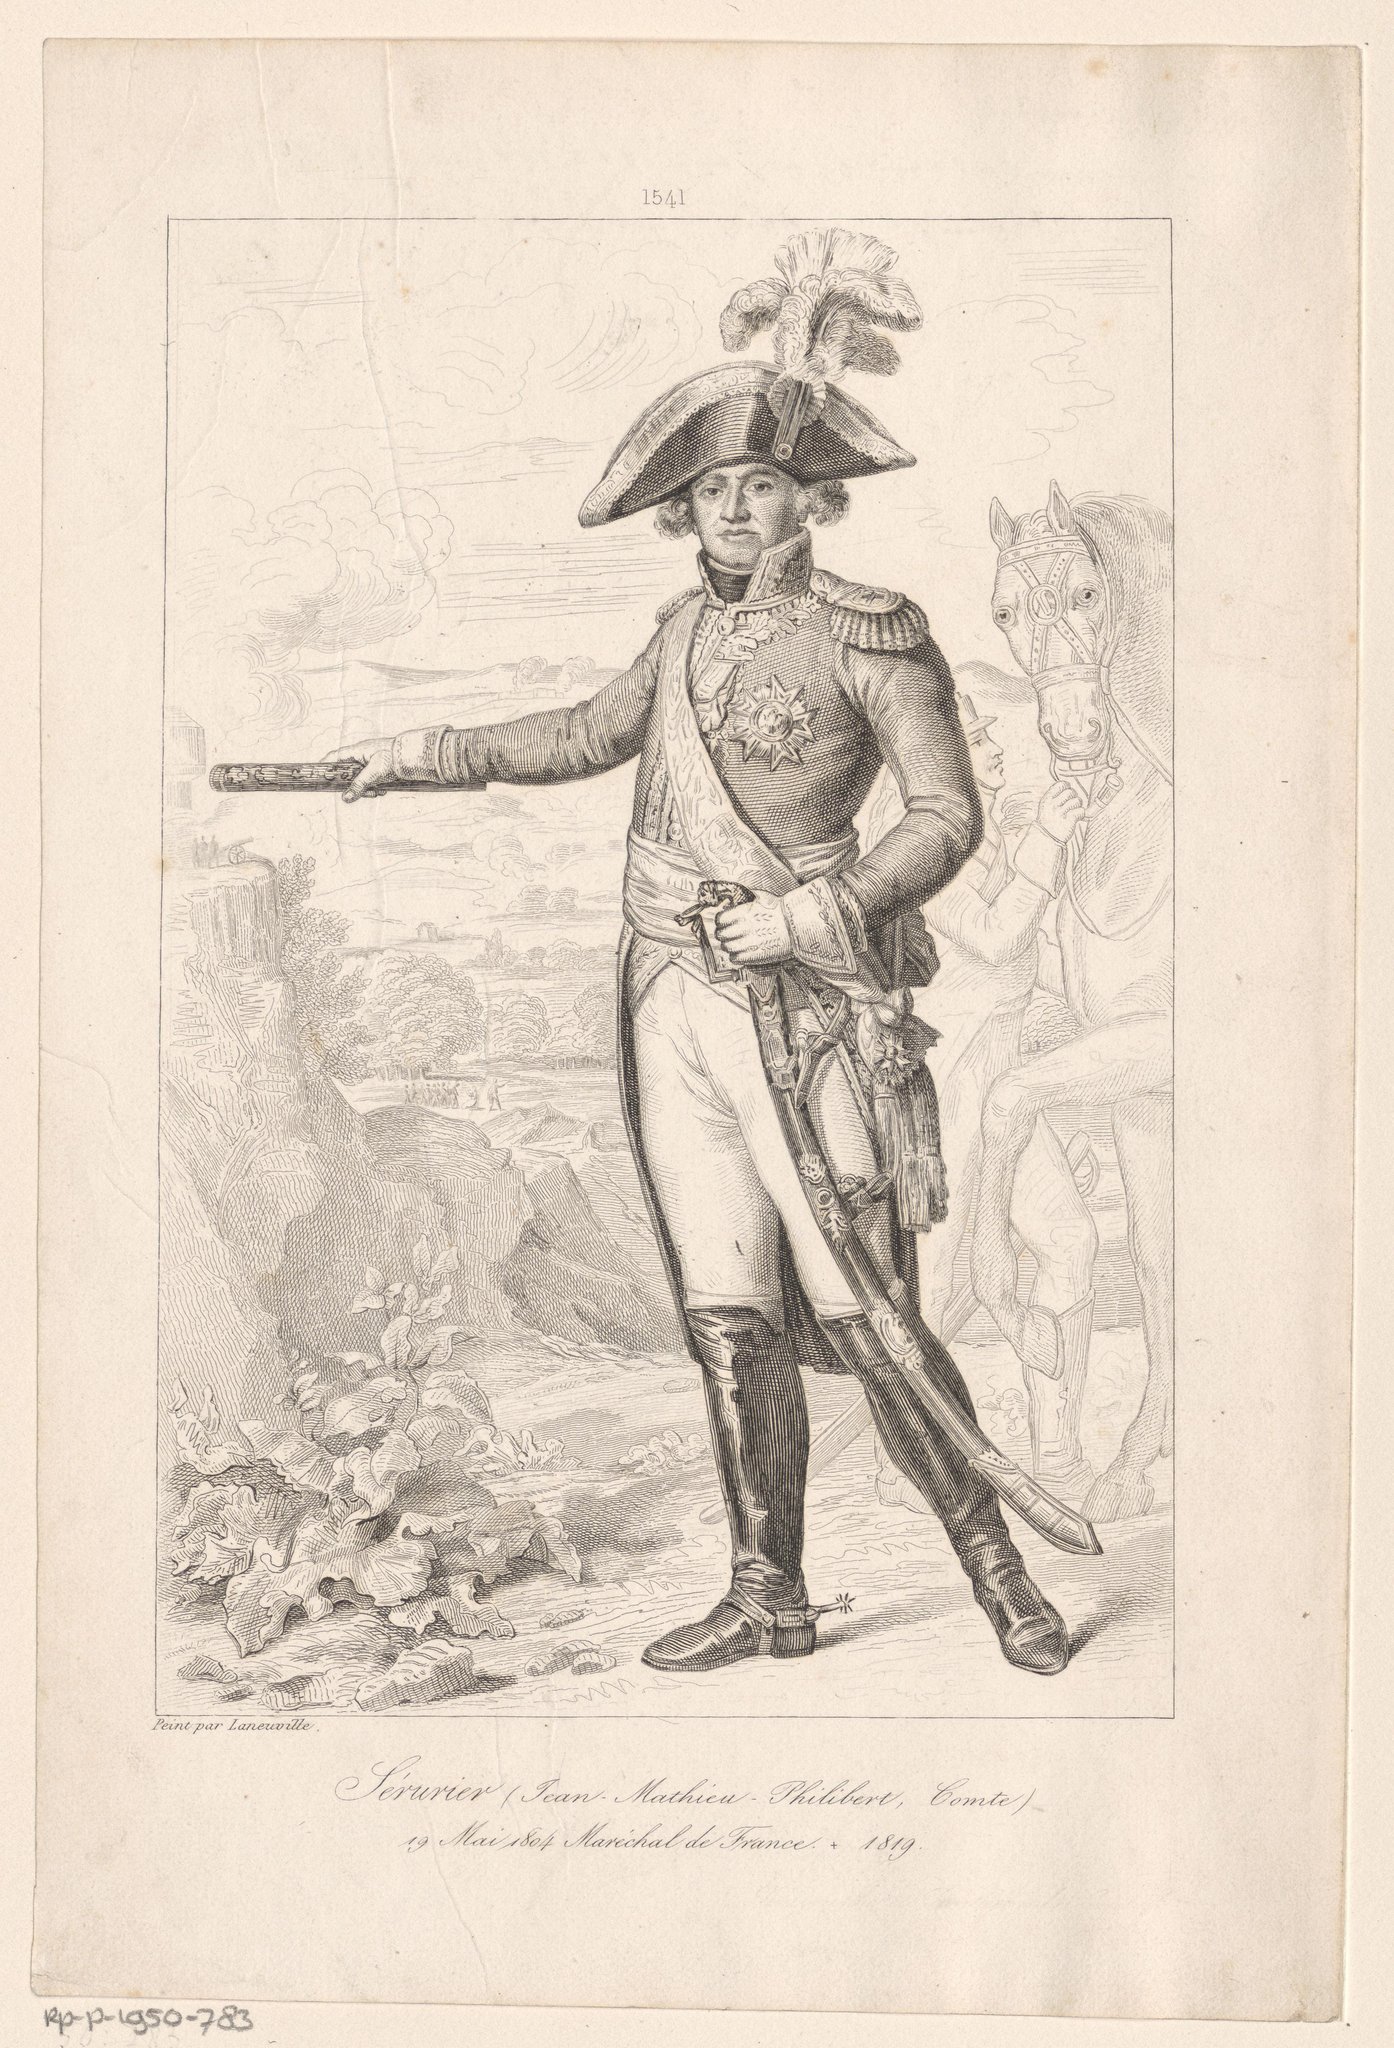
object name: print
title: Portret van Jean-Mathieu-Philibert Sérurier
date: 1839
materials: paper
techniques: etching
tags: politician, commander-in-chief, general, marshal, historical persons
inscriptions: inscription: ‘In 1793 generaal / Bijge[...]d de campagnes van 1792, 1793, II, III, IV, V, enz. / legers/Italië, Alpen en Italië, Engeland’, collector's mark: Lugt 2228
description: Prent waarschijnlijk uit: Gavard, Charles. Galerie des maréchaux de France (...). Parijs: Bureau des Galeries Historiques de Versailles, 1839.